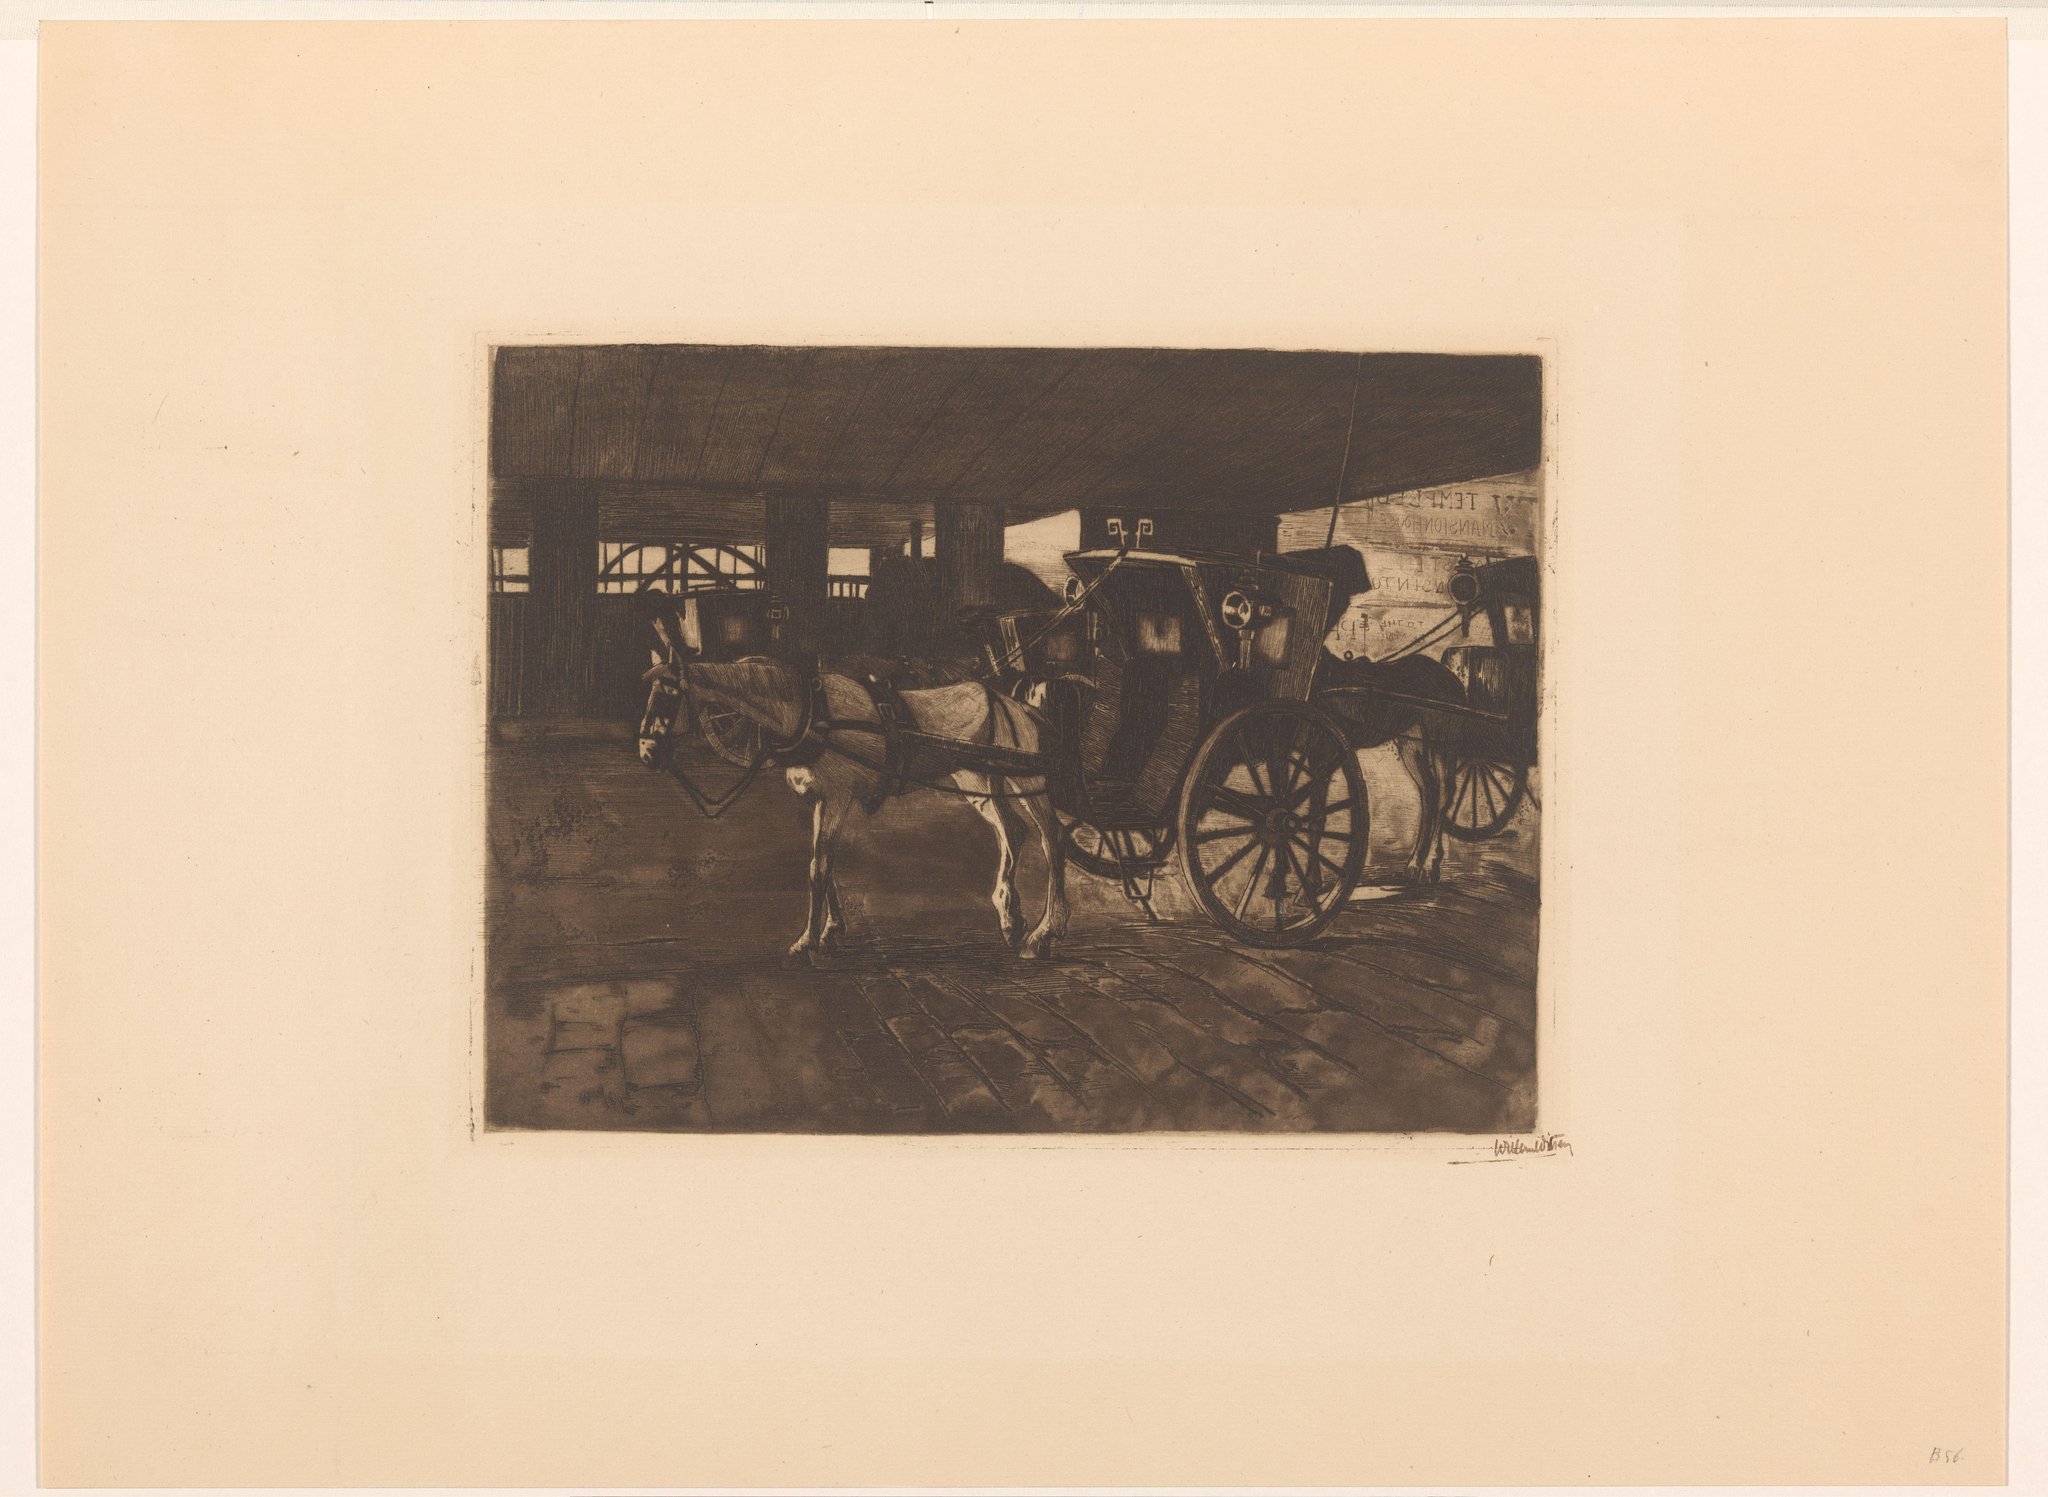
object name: print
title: Wachtende rijtuigen onder de Charing Cross Bridge in Londen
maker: willem witsen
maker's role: draughtsman, painter, print maker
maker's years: 1860-1923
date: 1890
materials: paper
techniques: aquatint, etching, intaglio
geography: london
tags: horse, bridge, passenger carriage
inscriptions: collector's mark: Lugt 2228, signature: ‘Willem Witsen’, watermark